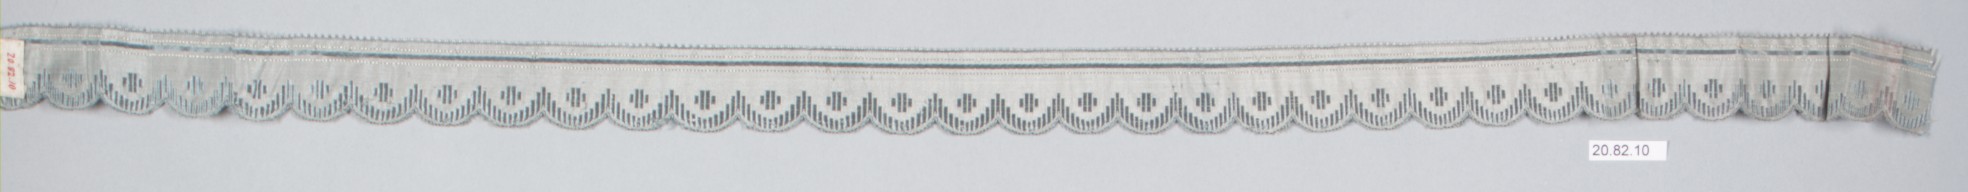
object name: ribbon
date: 1801-1833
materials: silk